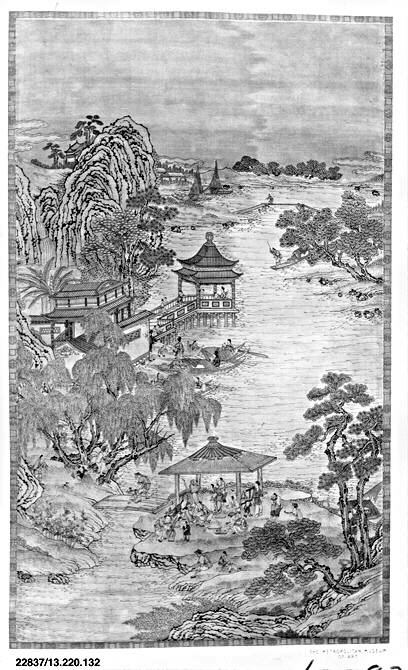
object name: picture, tapestry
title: Tapestry Picture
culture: chinese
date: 1801-1900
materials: silk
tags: landscapes,boats,pavilions